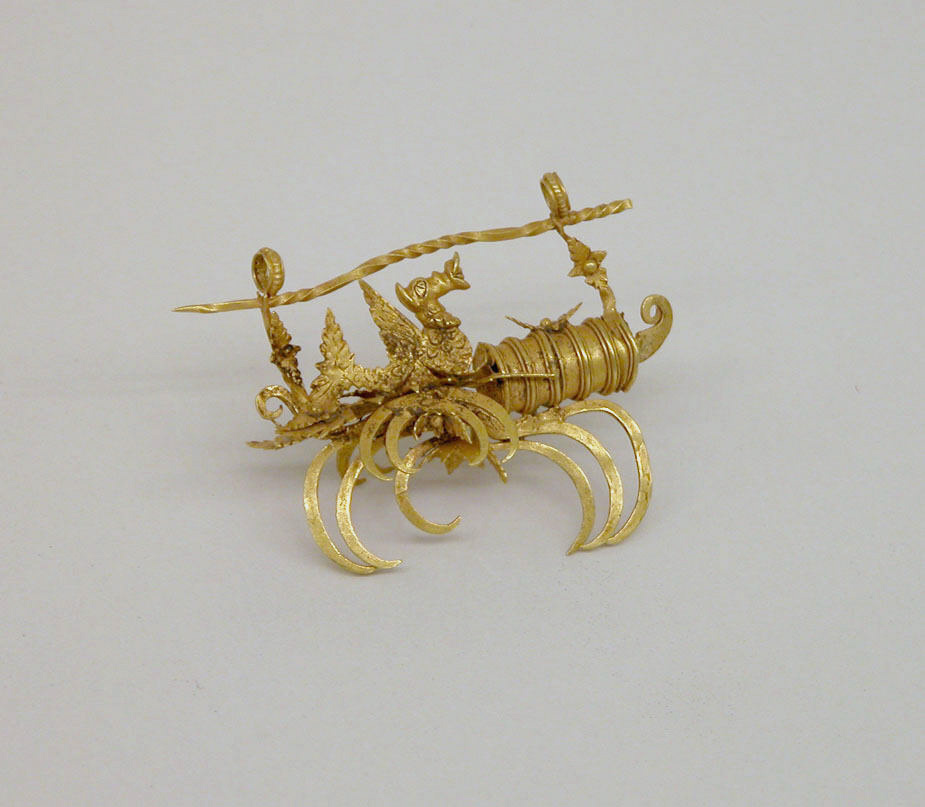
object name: pendant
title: Pendant with Zoomorphic Motif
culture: indonesian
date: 1801-2000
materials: gold